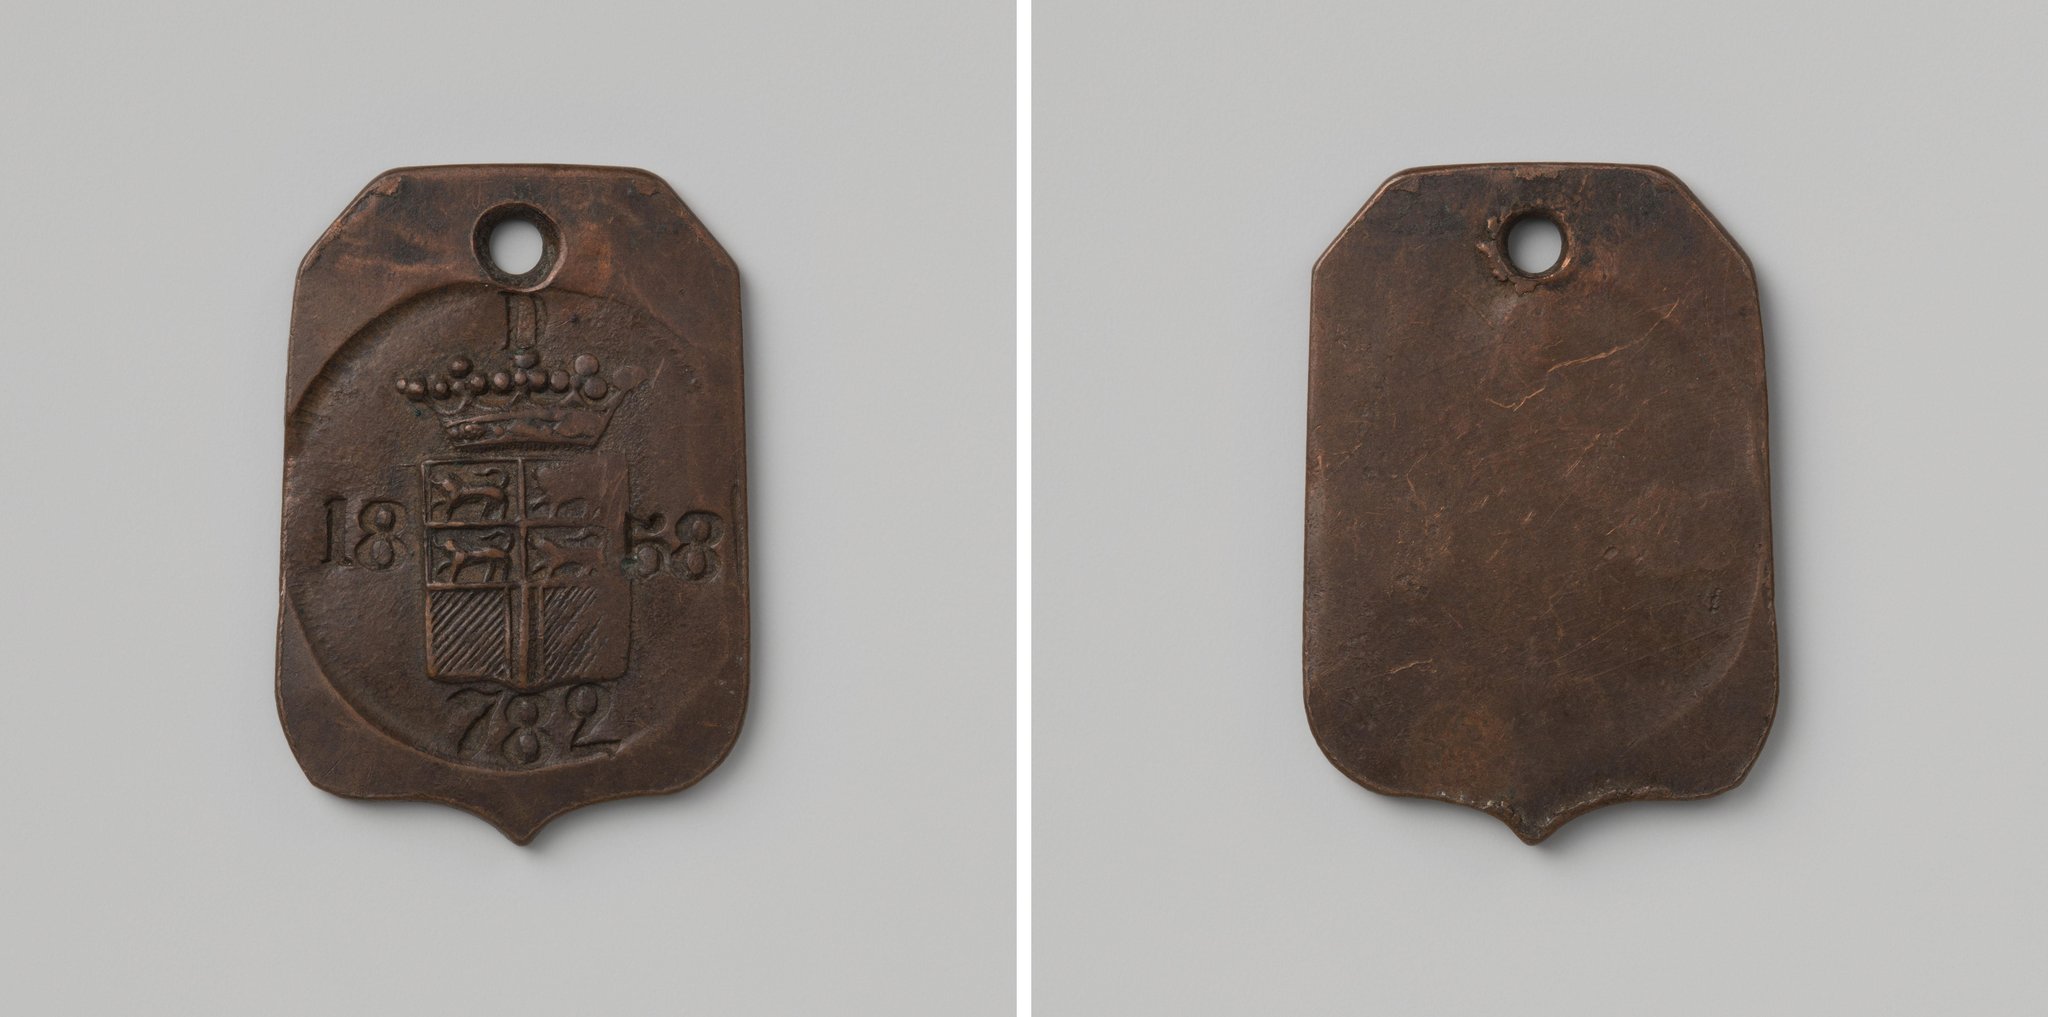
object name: tax token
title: Stad Rotterdam, loodje met letter D en no. 782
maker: Anonymous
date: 1858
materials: copper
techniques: striking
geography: rotterdam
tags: rotterdam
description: eenzijdig, ruitvormig loodje met aan bovenzijde afgeschuinde hoeken en gat, en aan onderzijde afgeronde hoeken en eindigend in punt. Voorzijde: gekroond wapenschild tussen jaartal boven cijfer 782; boven wapenschild: letter D. Keerzijde: blanco